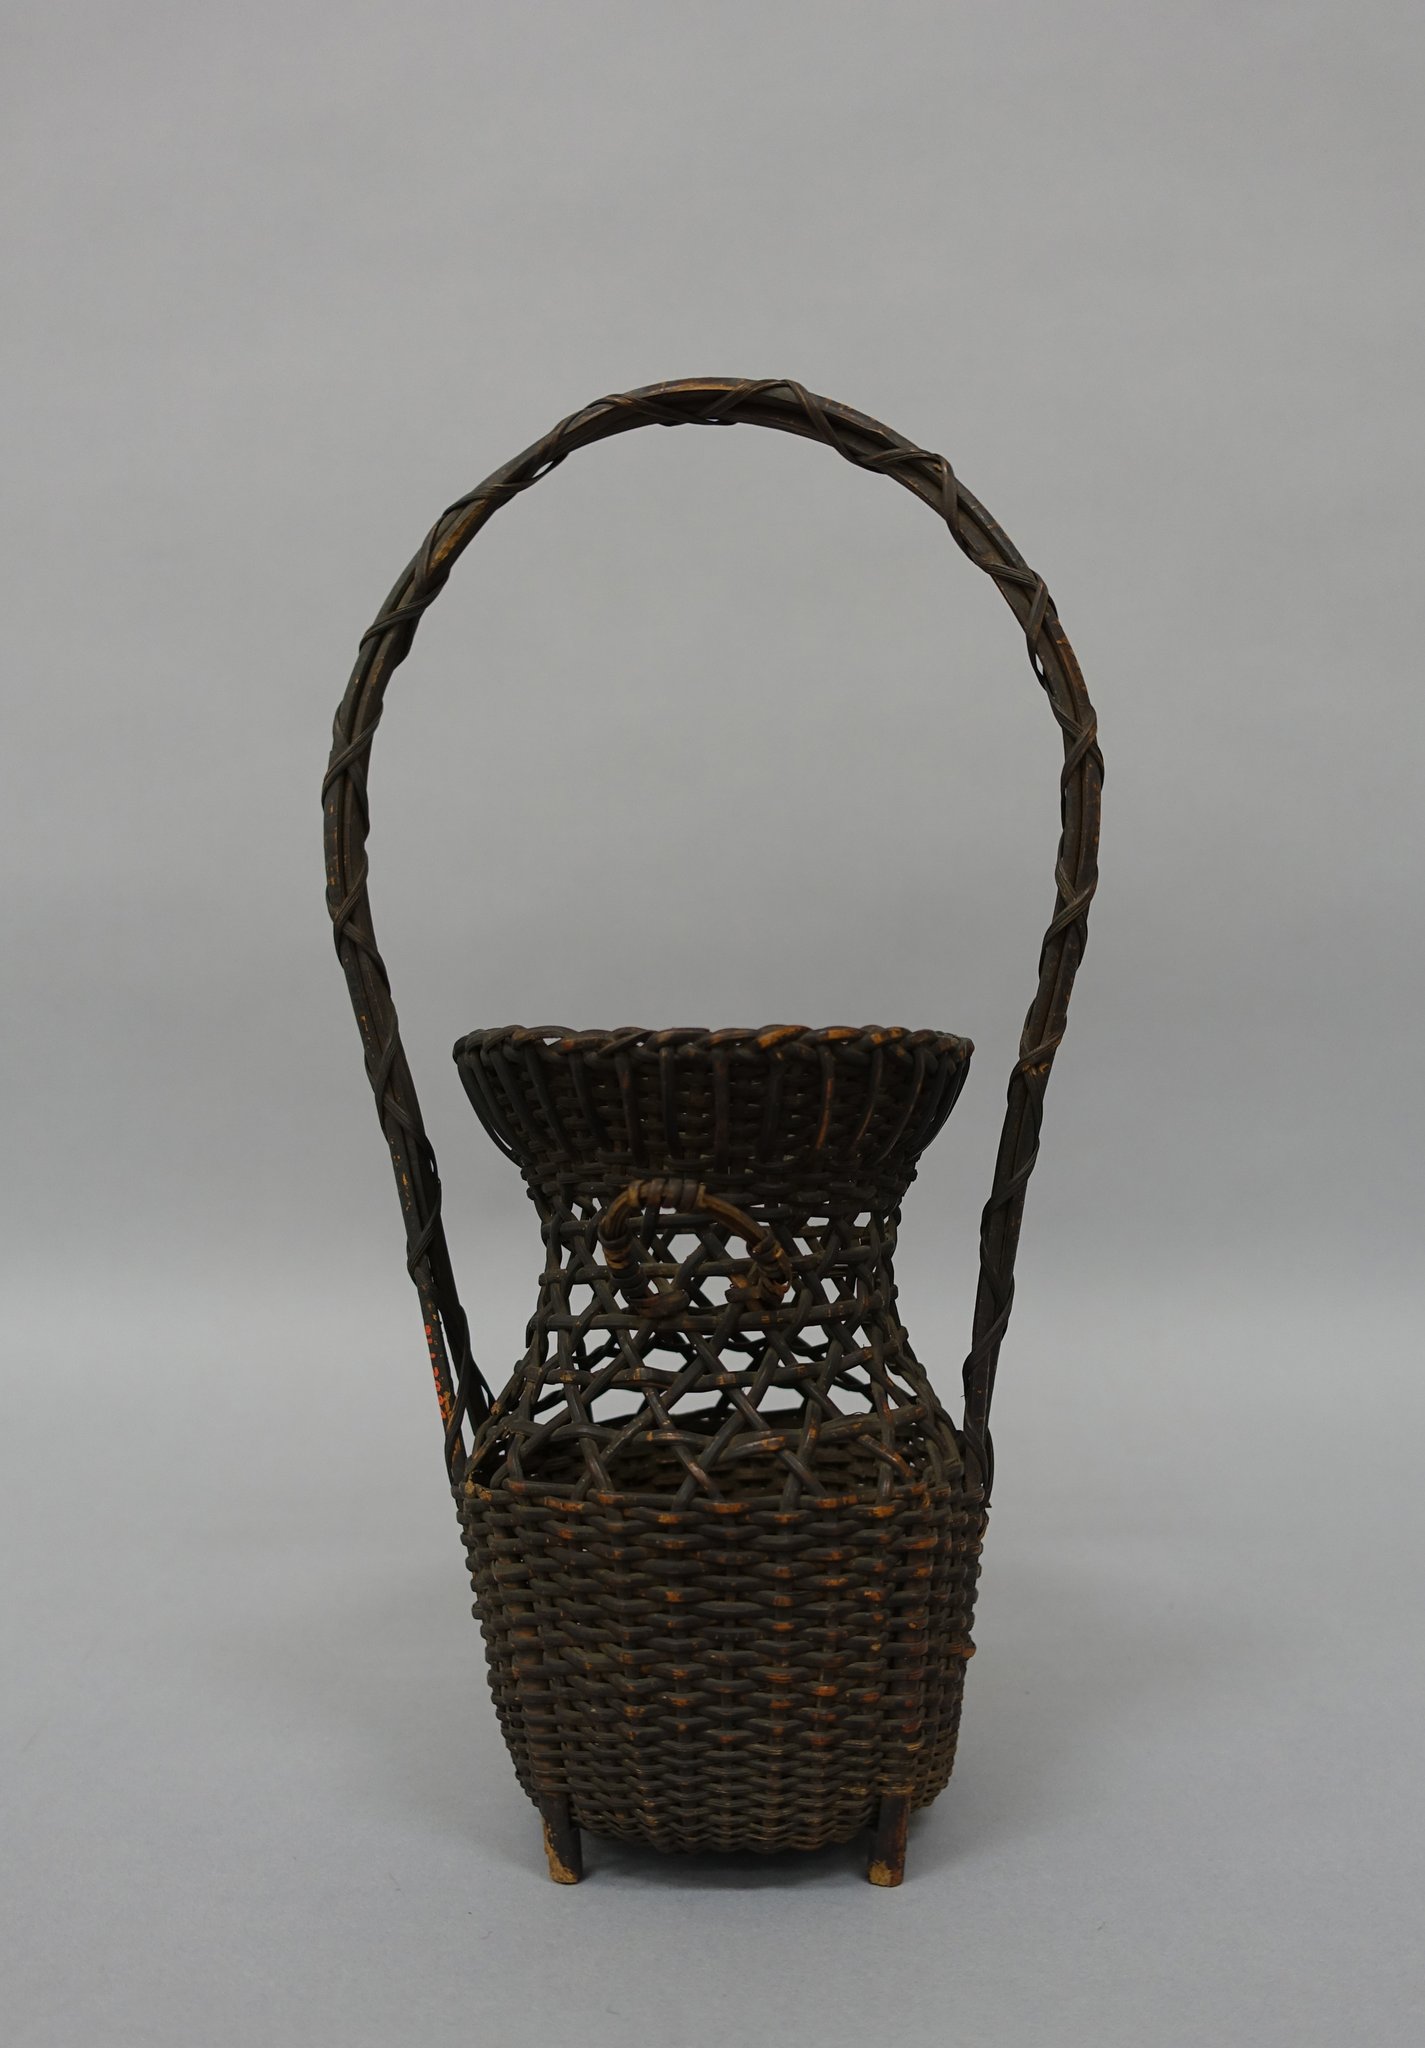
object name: basket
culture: japanese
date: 1801-1900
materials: bamboo